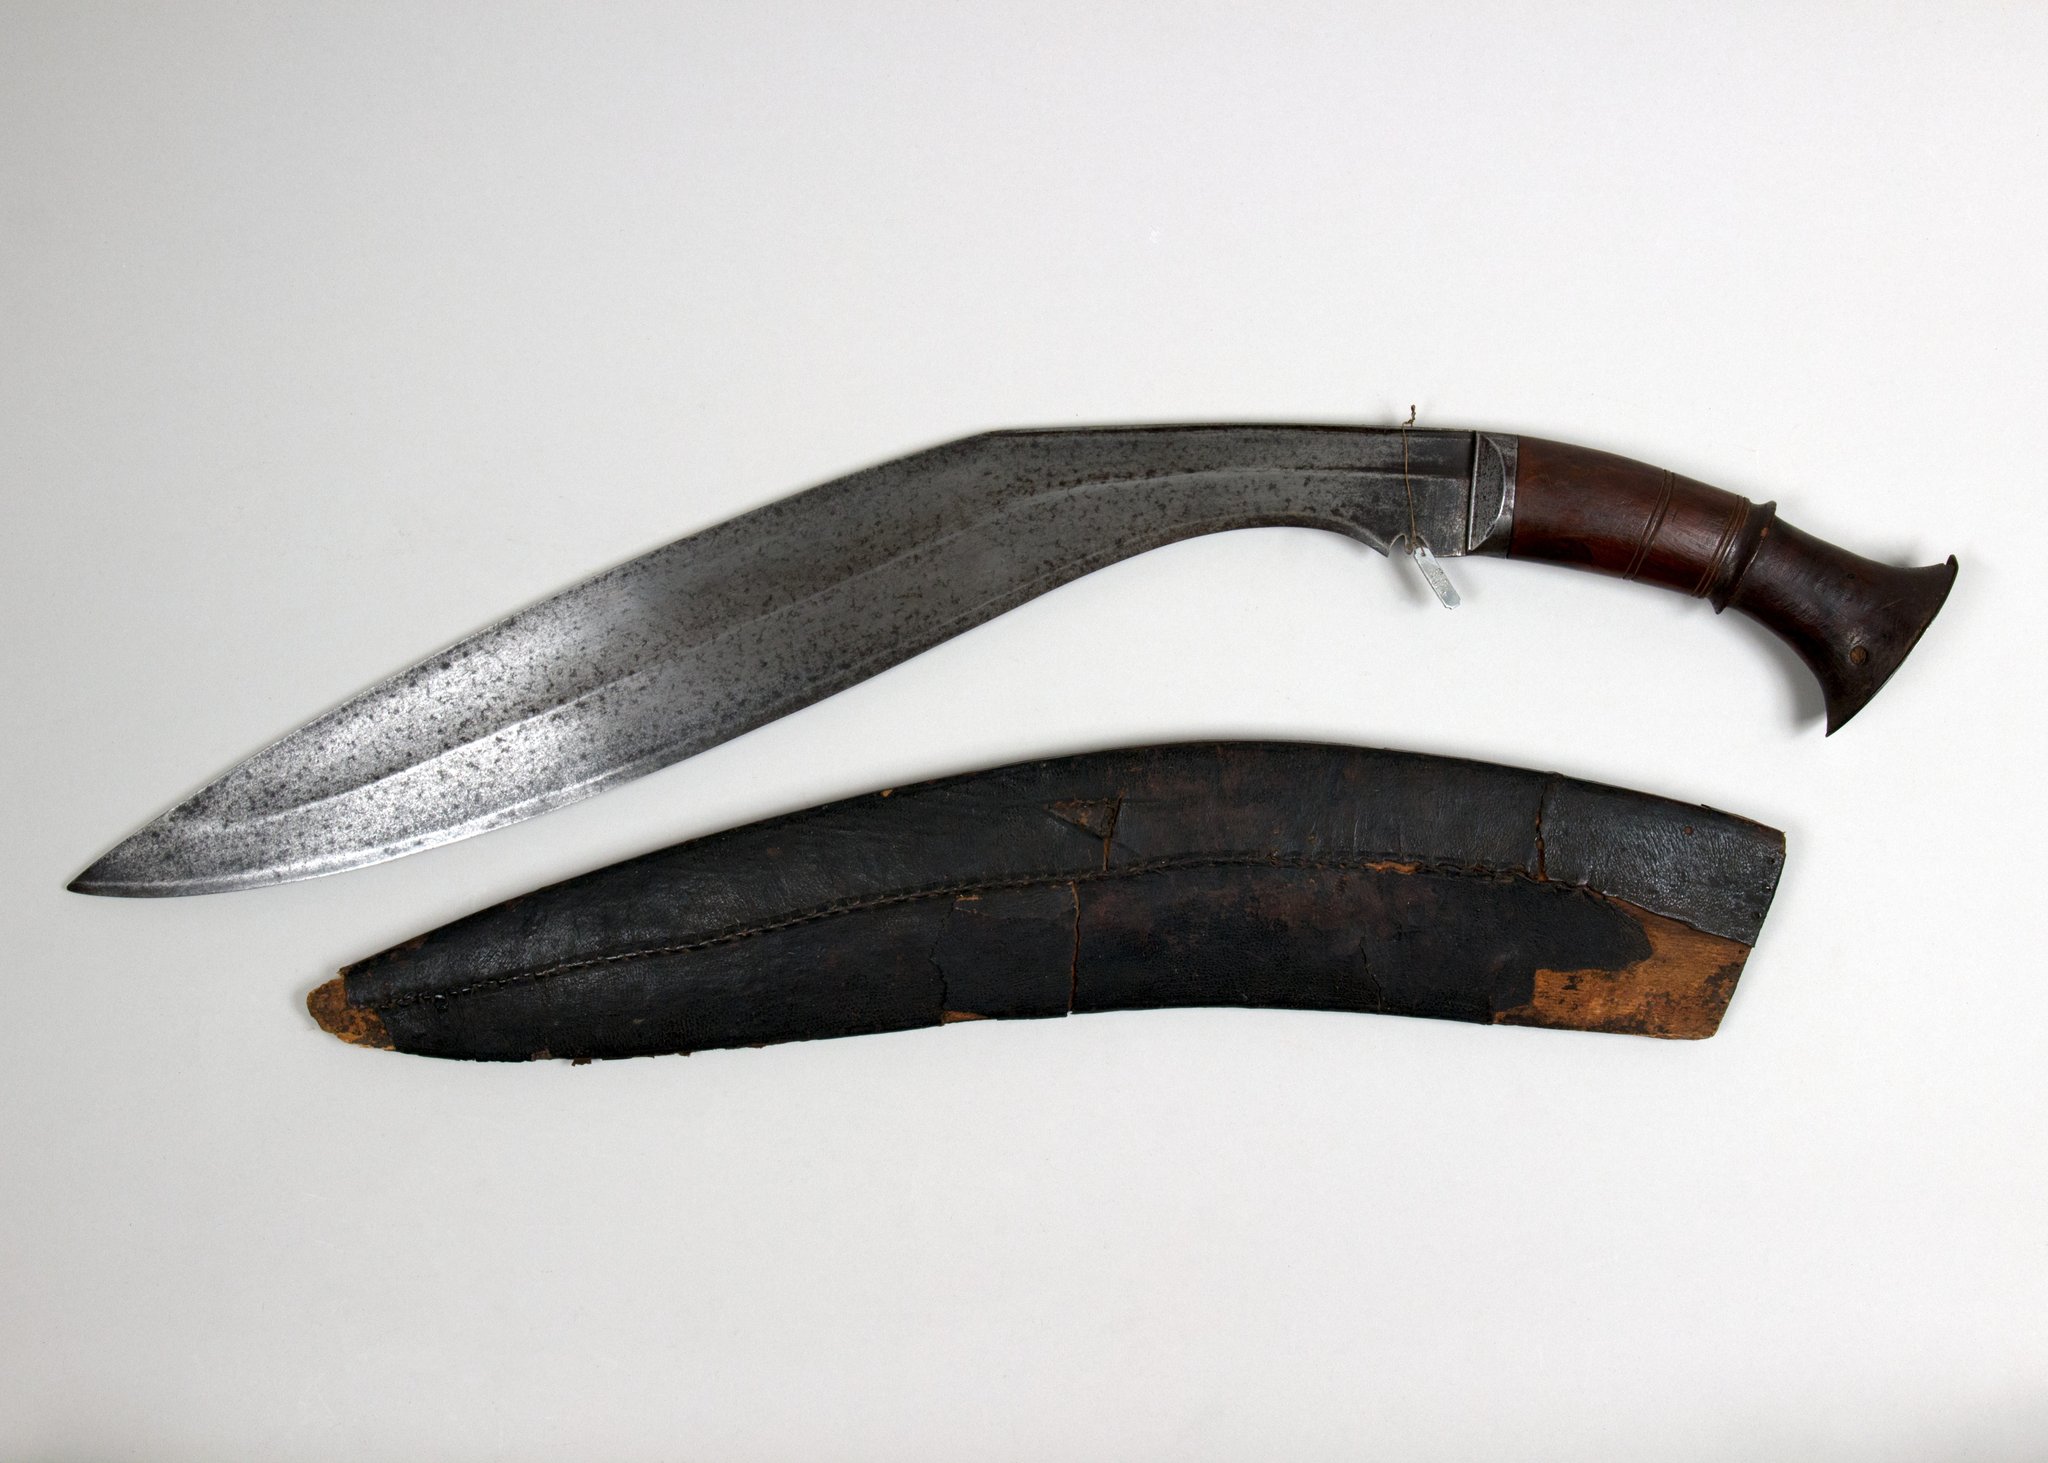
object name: knife kukri with sheath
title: Knife (Kukri) with Sheath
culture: nepalese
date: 1701-1900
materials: wood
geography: nepal